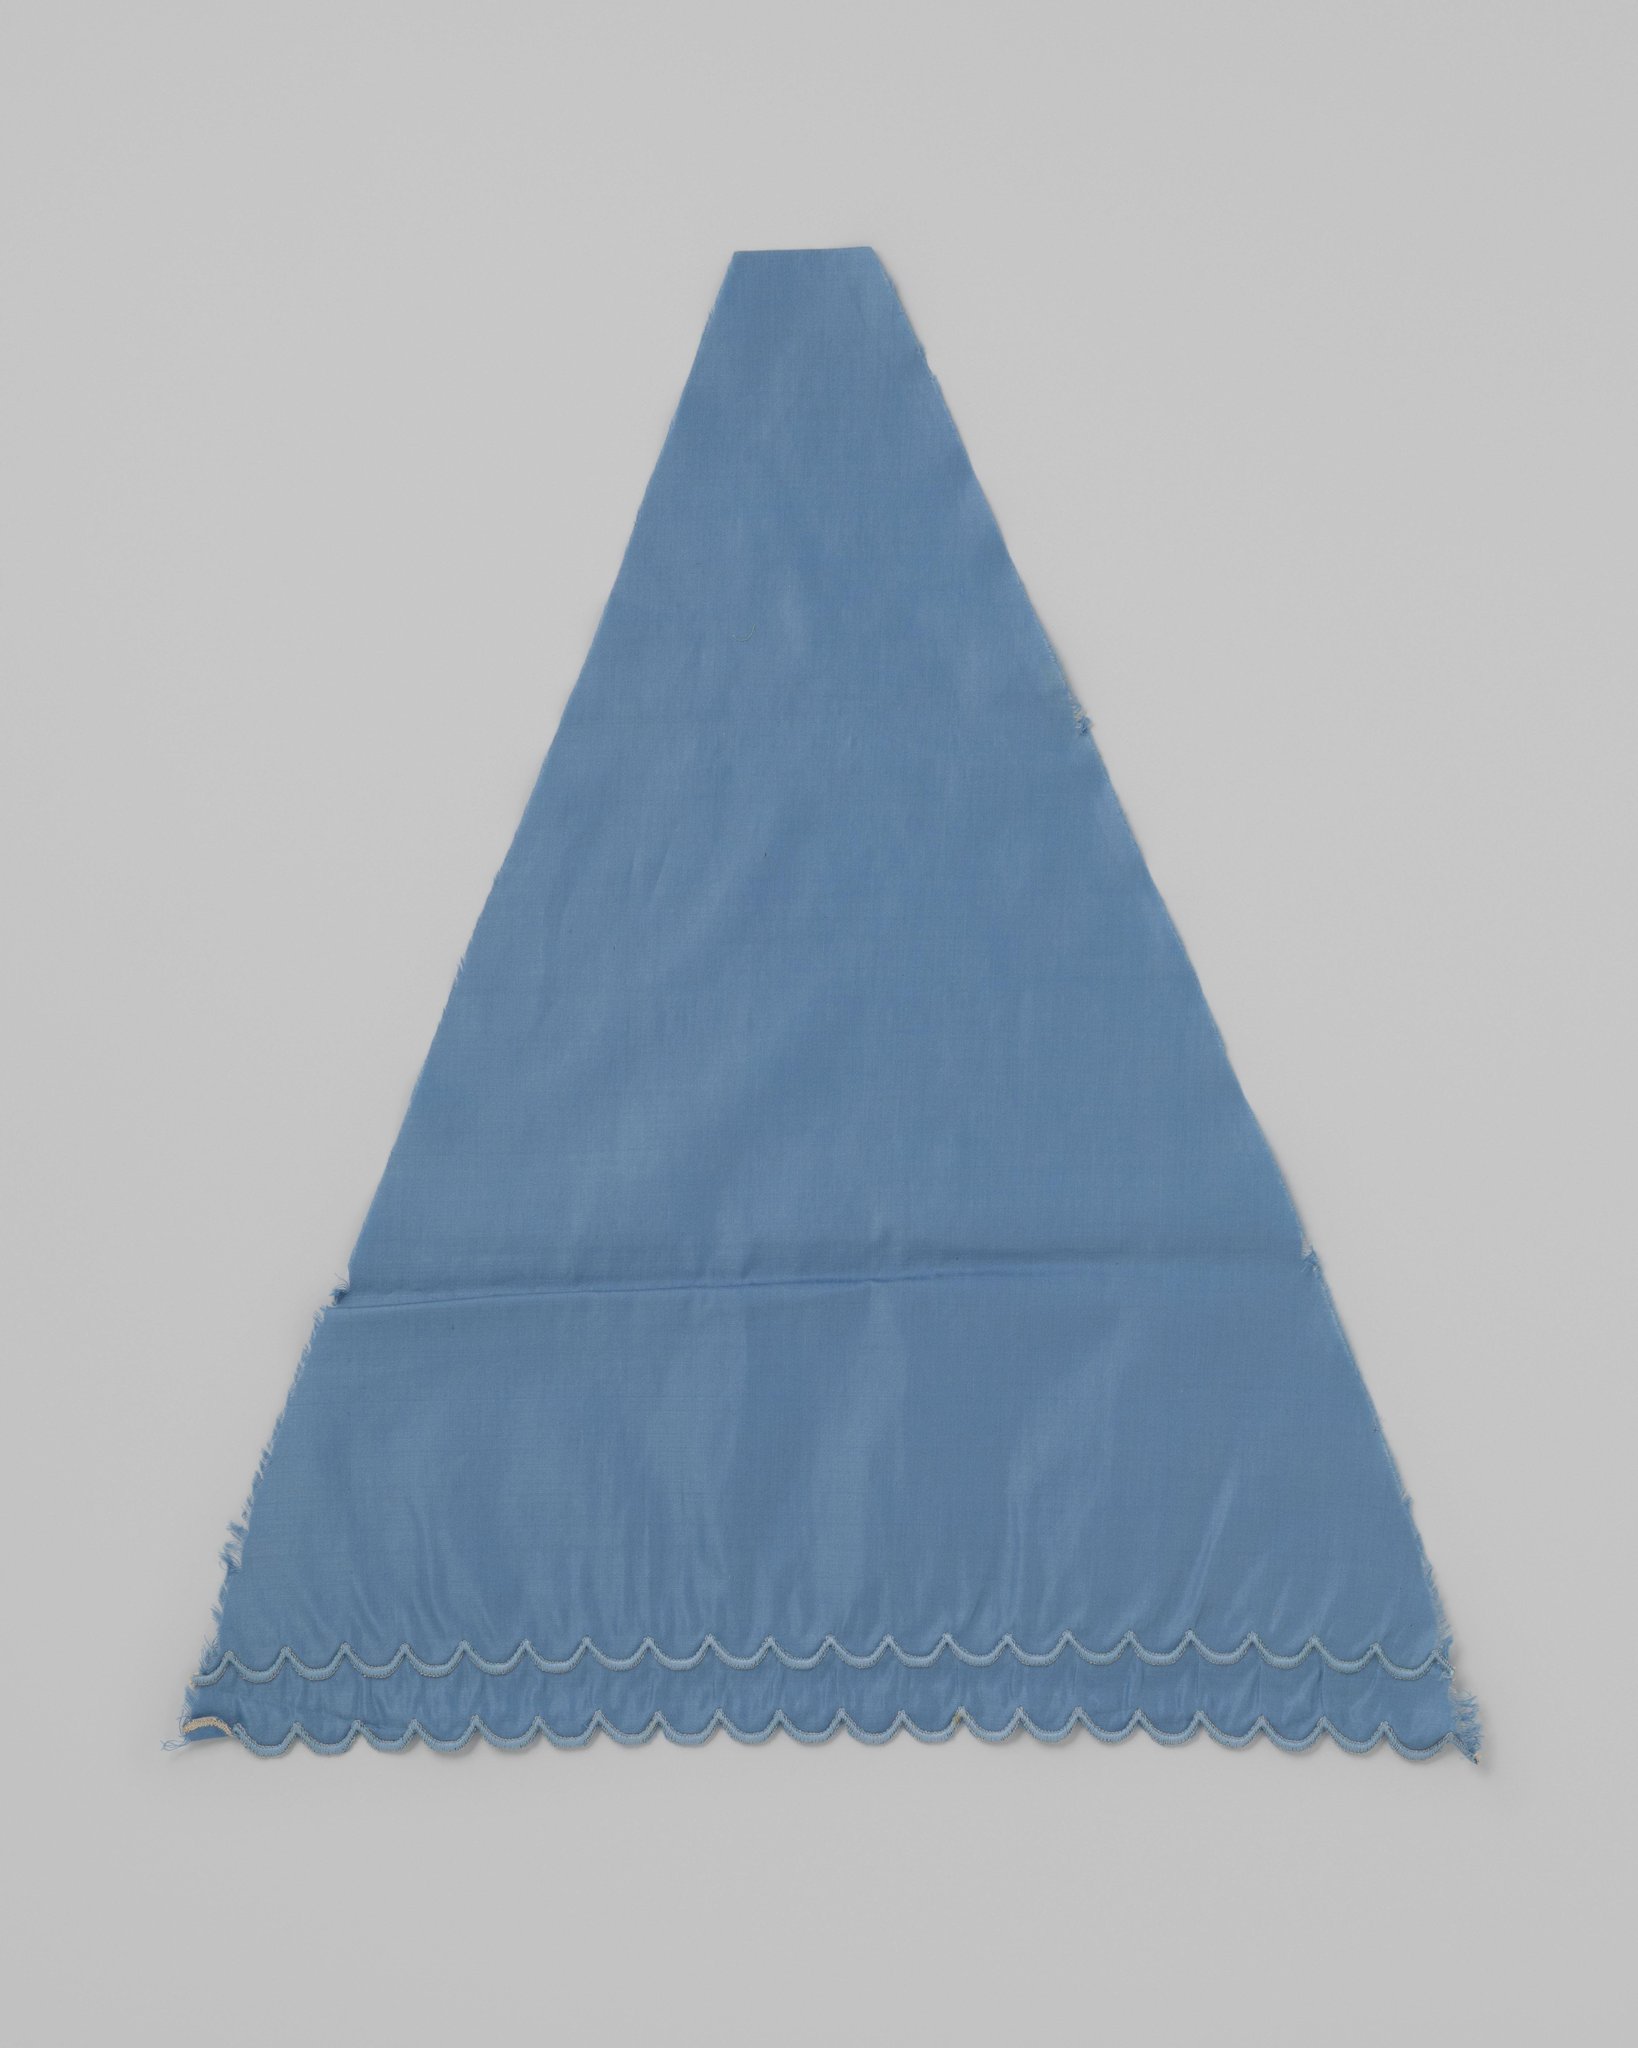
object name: parasoldek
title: Sector van een parasoldek van lichtblauw katoen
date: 1885-1900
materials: cotton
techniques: festoon stitch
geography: nijmegen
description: Sector van een parasoldek van lichtblauw katoen. Met een dubbele rij gefestonneerde schulpen.